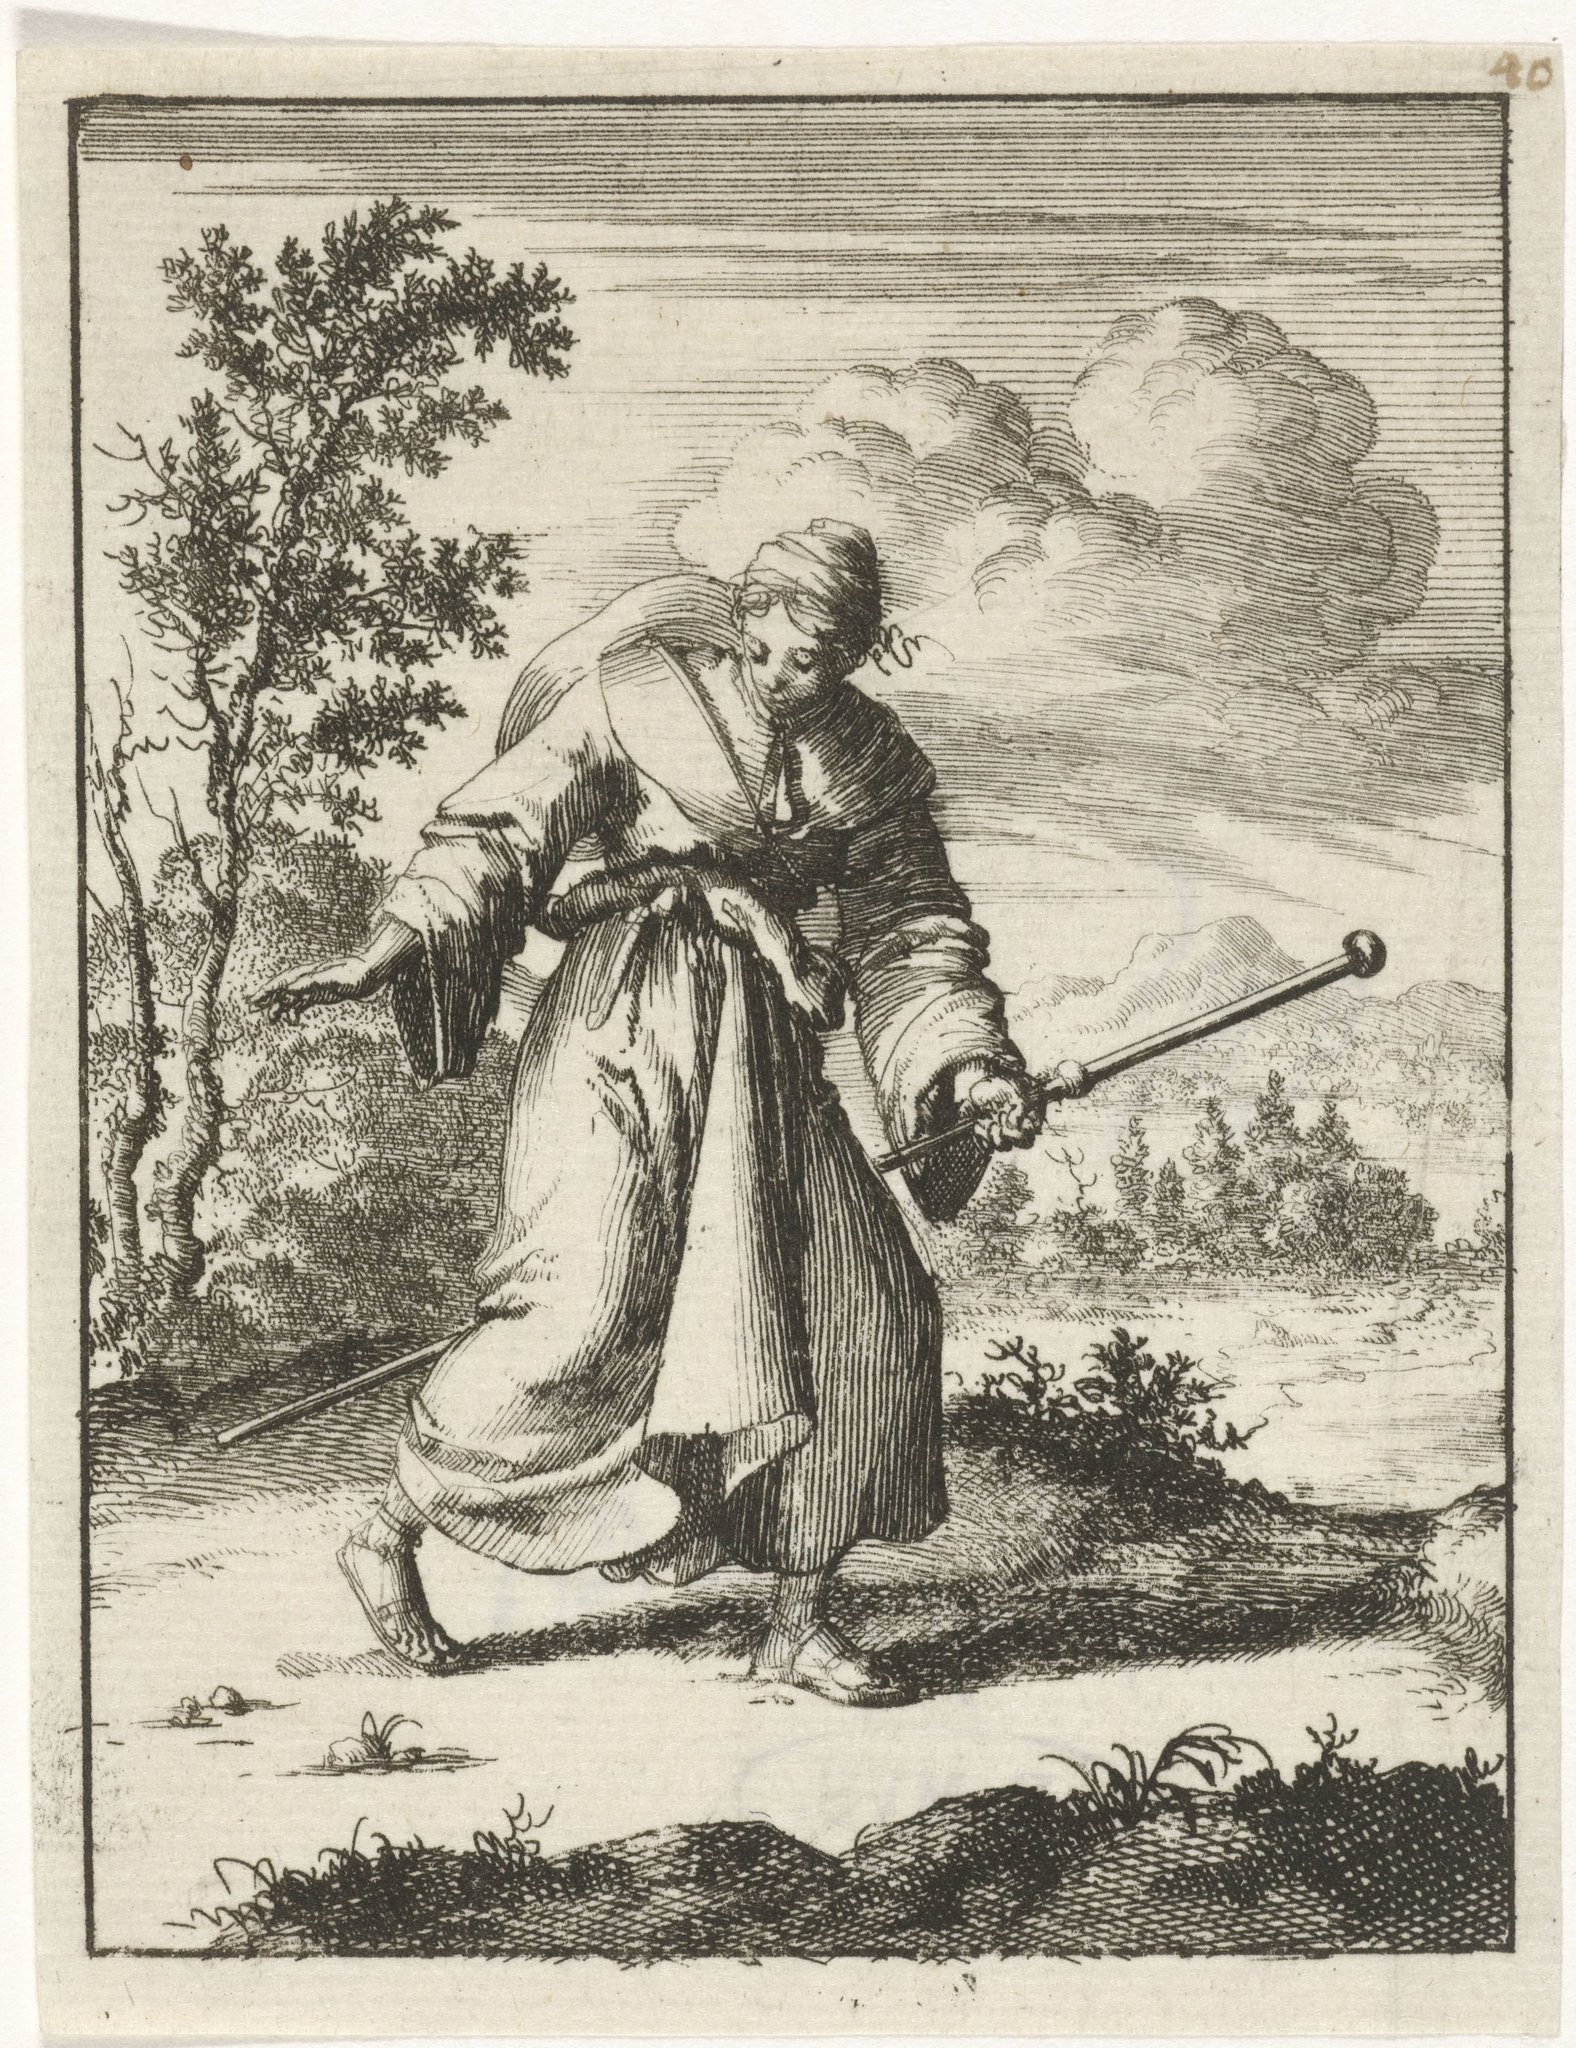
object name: print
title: Oost, west, t' Huys best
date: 1687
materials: paper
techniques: etching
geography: amsterdam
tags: pilgrim(s), walking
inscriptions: number: ‘40’, collector's mark: Lugt 2228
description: Illustratie uit: Luyken, Jan. Voncken der liefde Jesu, van het godtbegerende zielenvier. Amsterdam: Pieter Arentsz (II), 1687, p. 170.